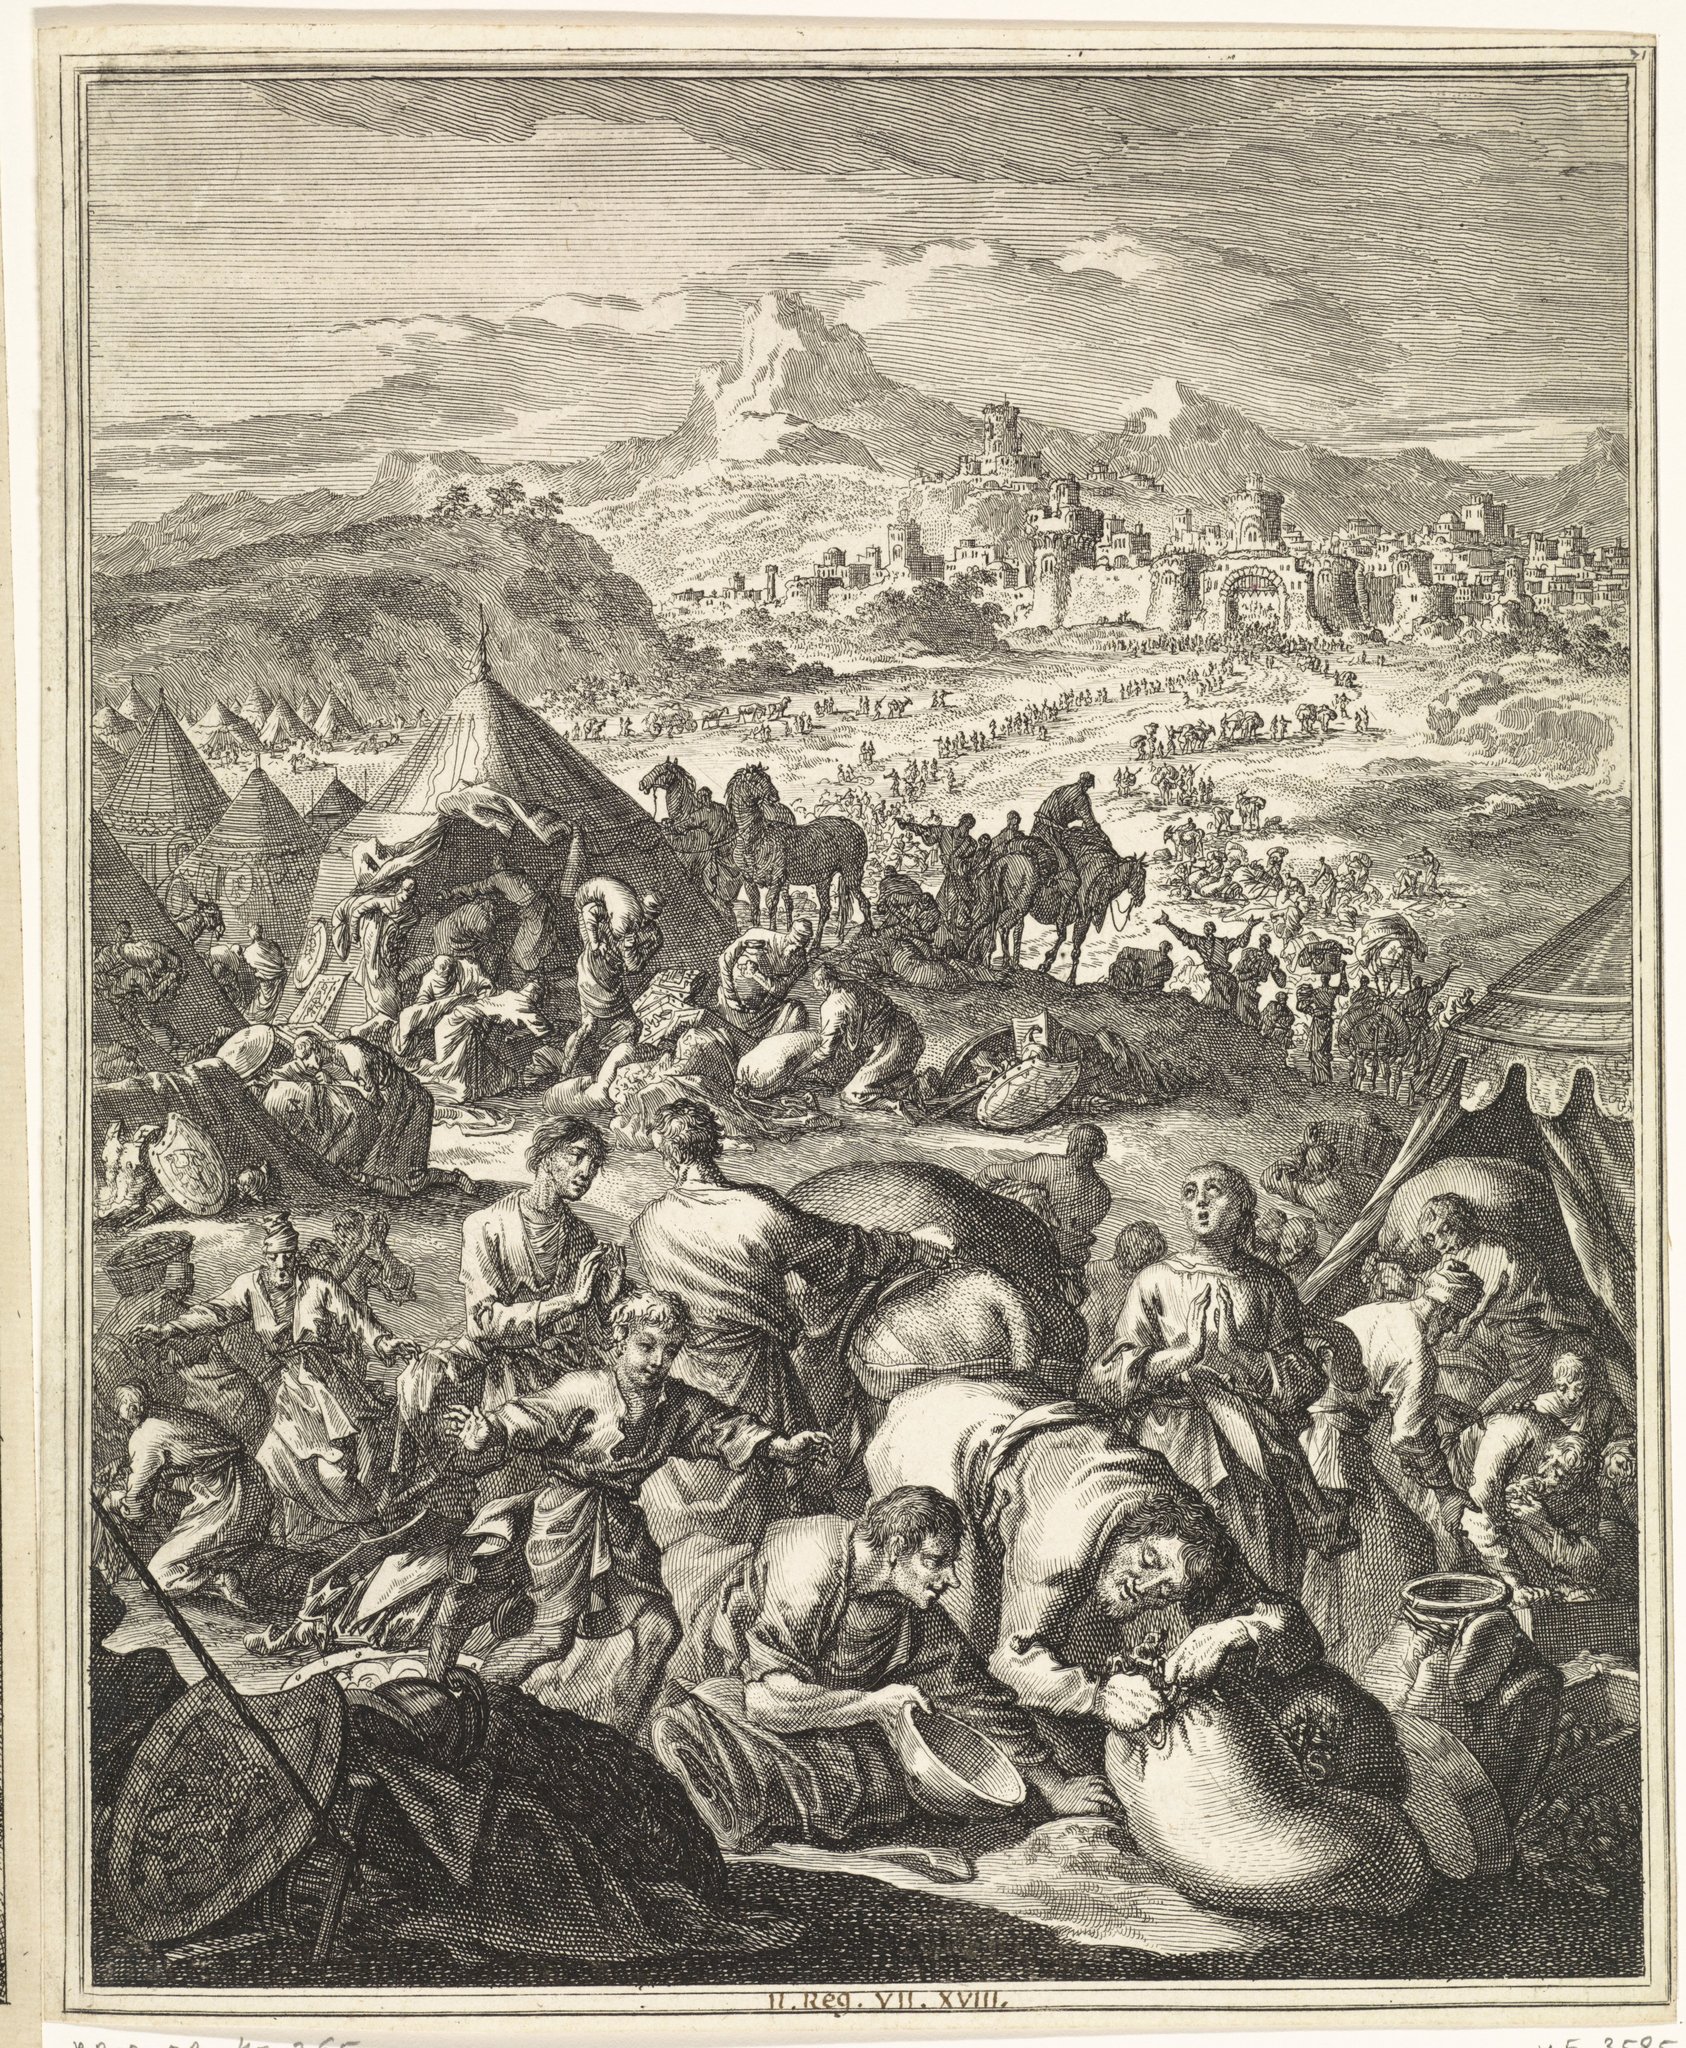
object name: print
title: Verloste bewoners van Samaria vinden overvloedig levensmiddelen in het door Syriërs verlaten kamp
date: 1708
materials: paper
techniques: etching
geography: amsterdam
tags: the people of samaria rush out and loot the syrian camp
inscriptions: collector's mark: Lugt 2228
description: Proefdruk van een prent welke is opgenomen als illustratie in: Historiae Celebriores Veteris Testamenti. Christoph Weigel, 1708.